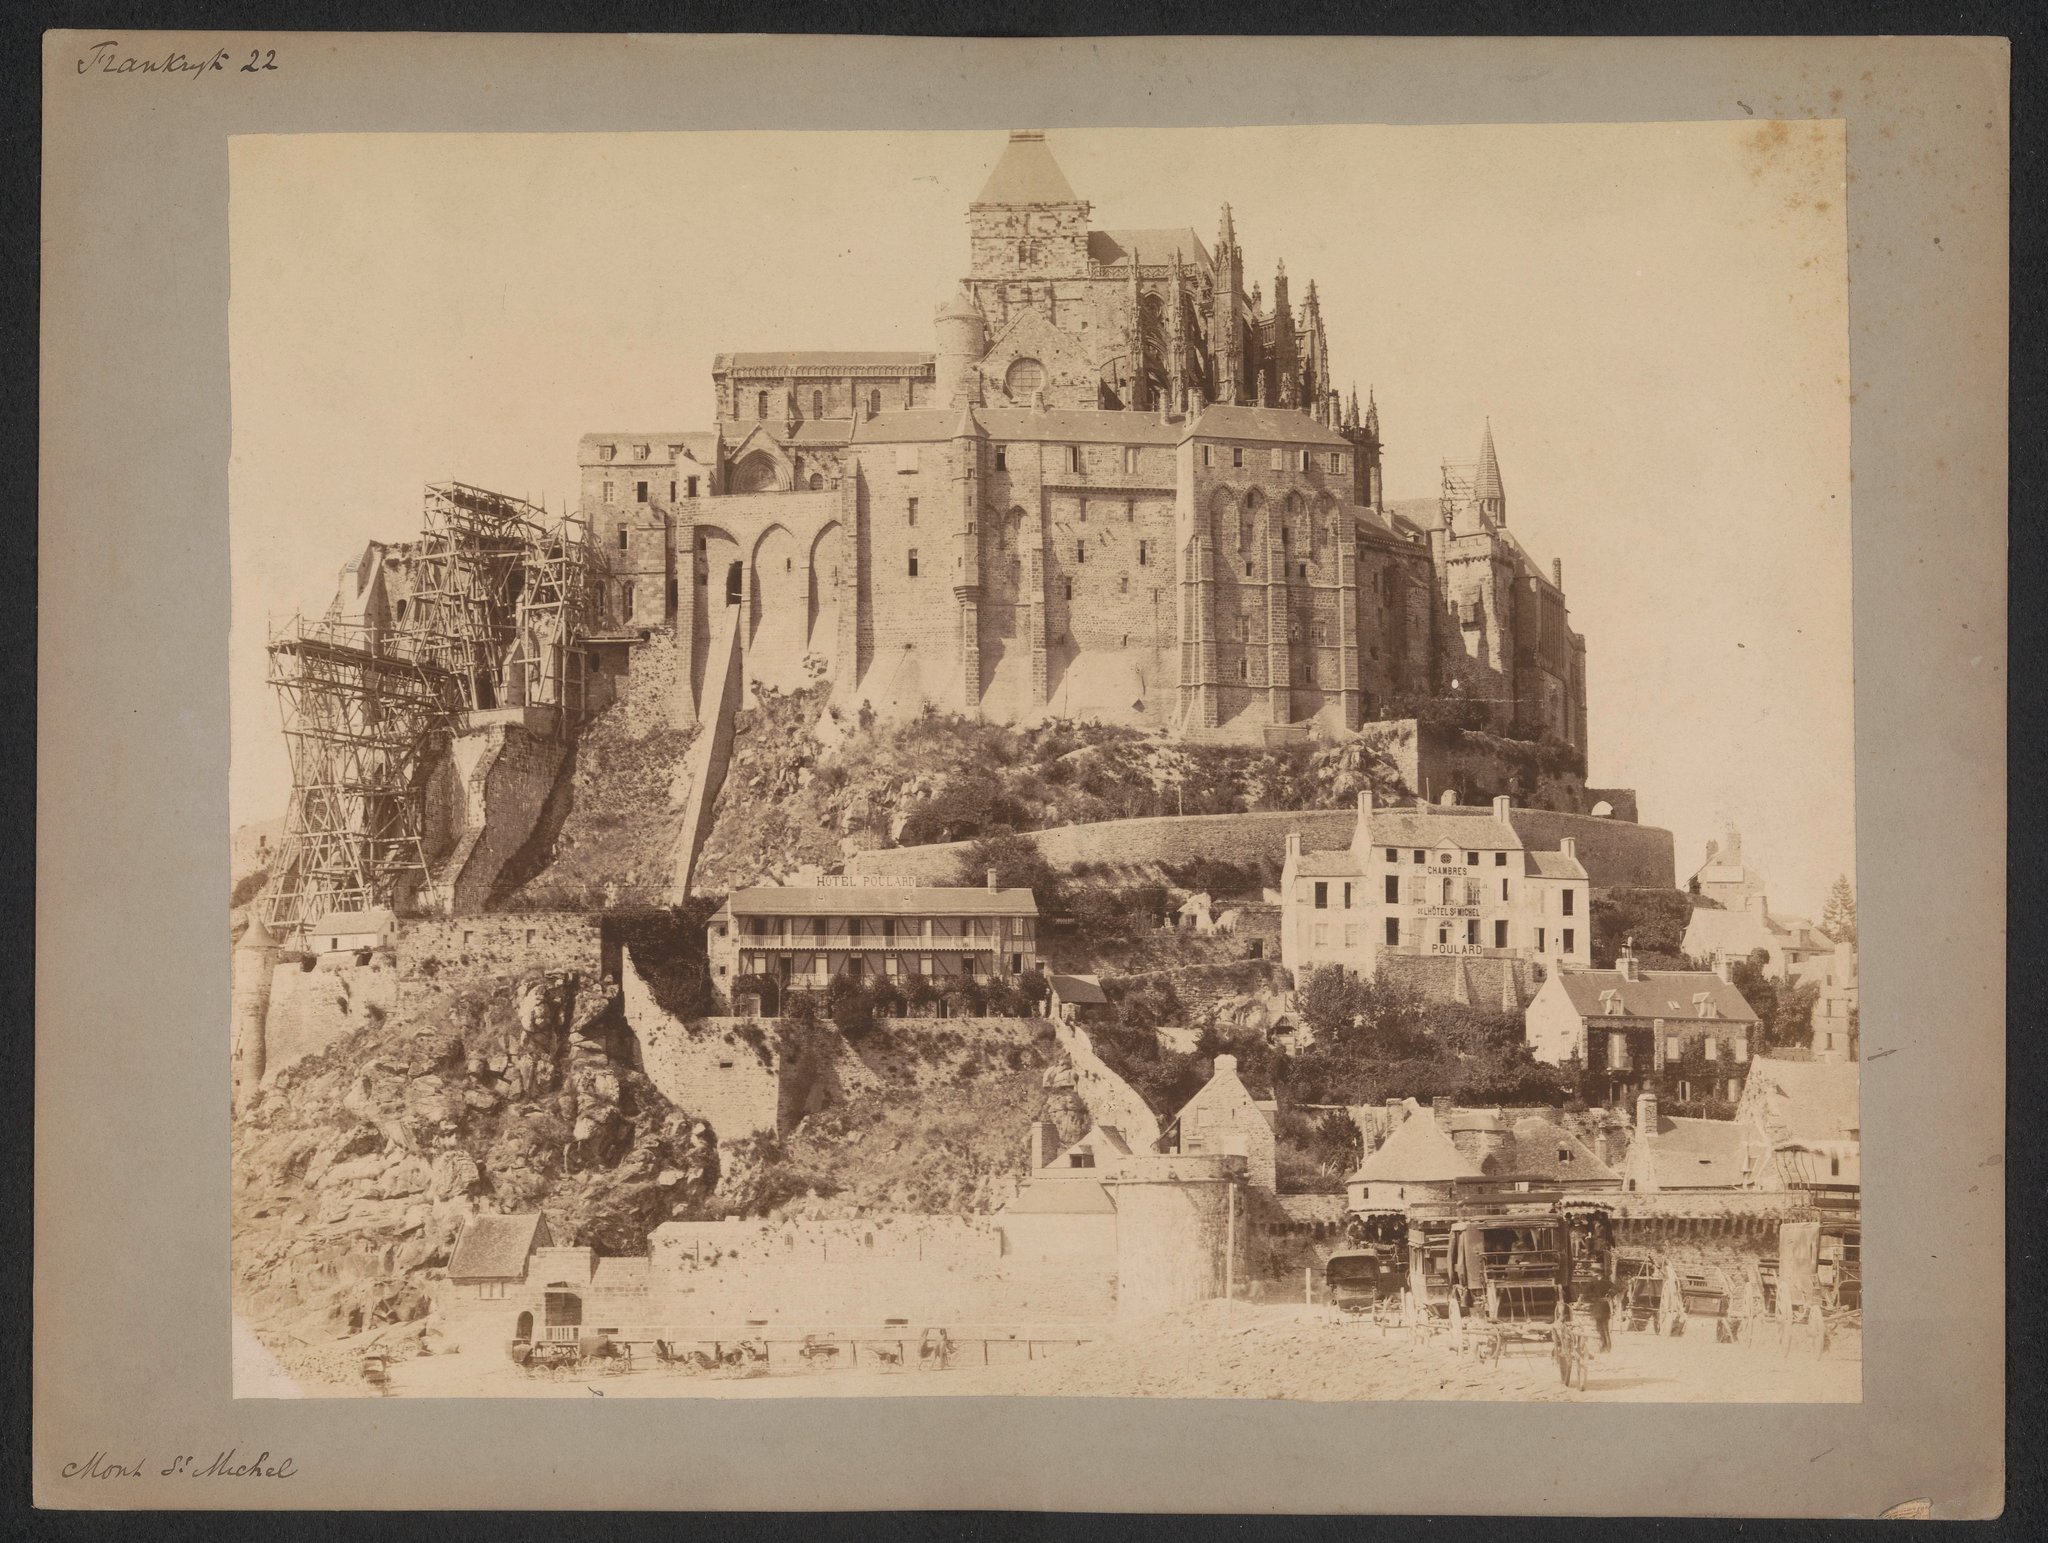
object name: photograph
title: Gezicht op Mont-Saint-Michel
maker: Anonymous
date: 1850-1900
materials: cardboard, photographic support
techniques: albumen print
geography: mont-saint-michel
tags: city-view, and landscape with man-made constructions, mountains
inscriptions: collector's mark: ‘RIJKS [NORMA]ALSCHOOL voor T[EEKENONDERWIJZERS] AMSTERDA[M]’, annotation: ‘Mont St. Michel’, annotation: ‘Mont S. Michel.’, annotation: ‘Frankrijk 22’